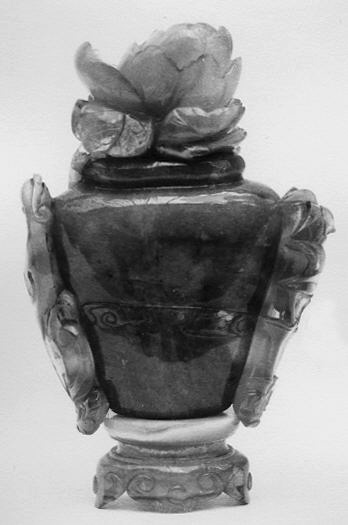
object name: vase with cover and base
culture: chinese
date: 1701-1800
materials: gemstone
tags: flowers